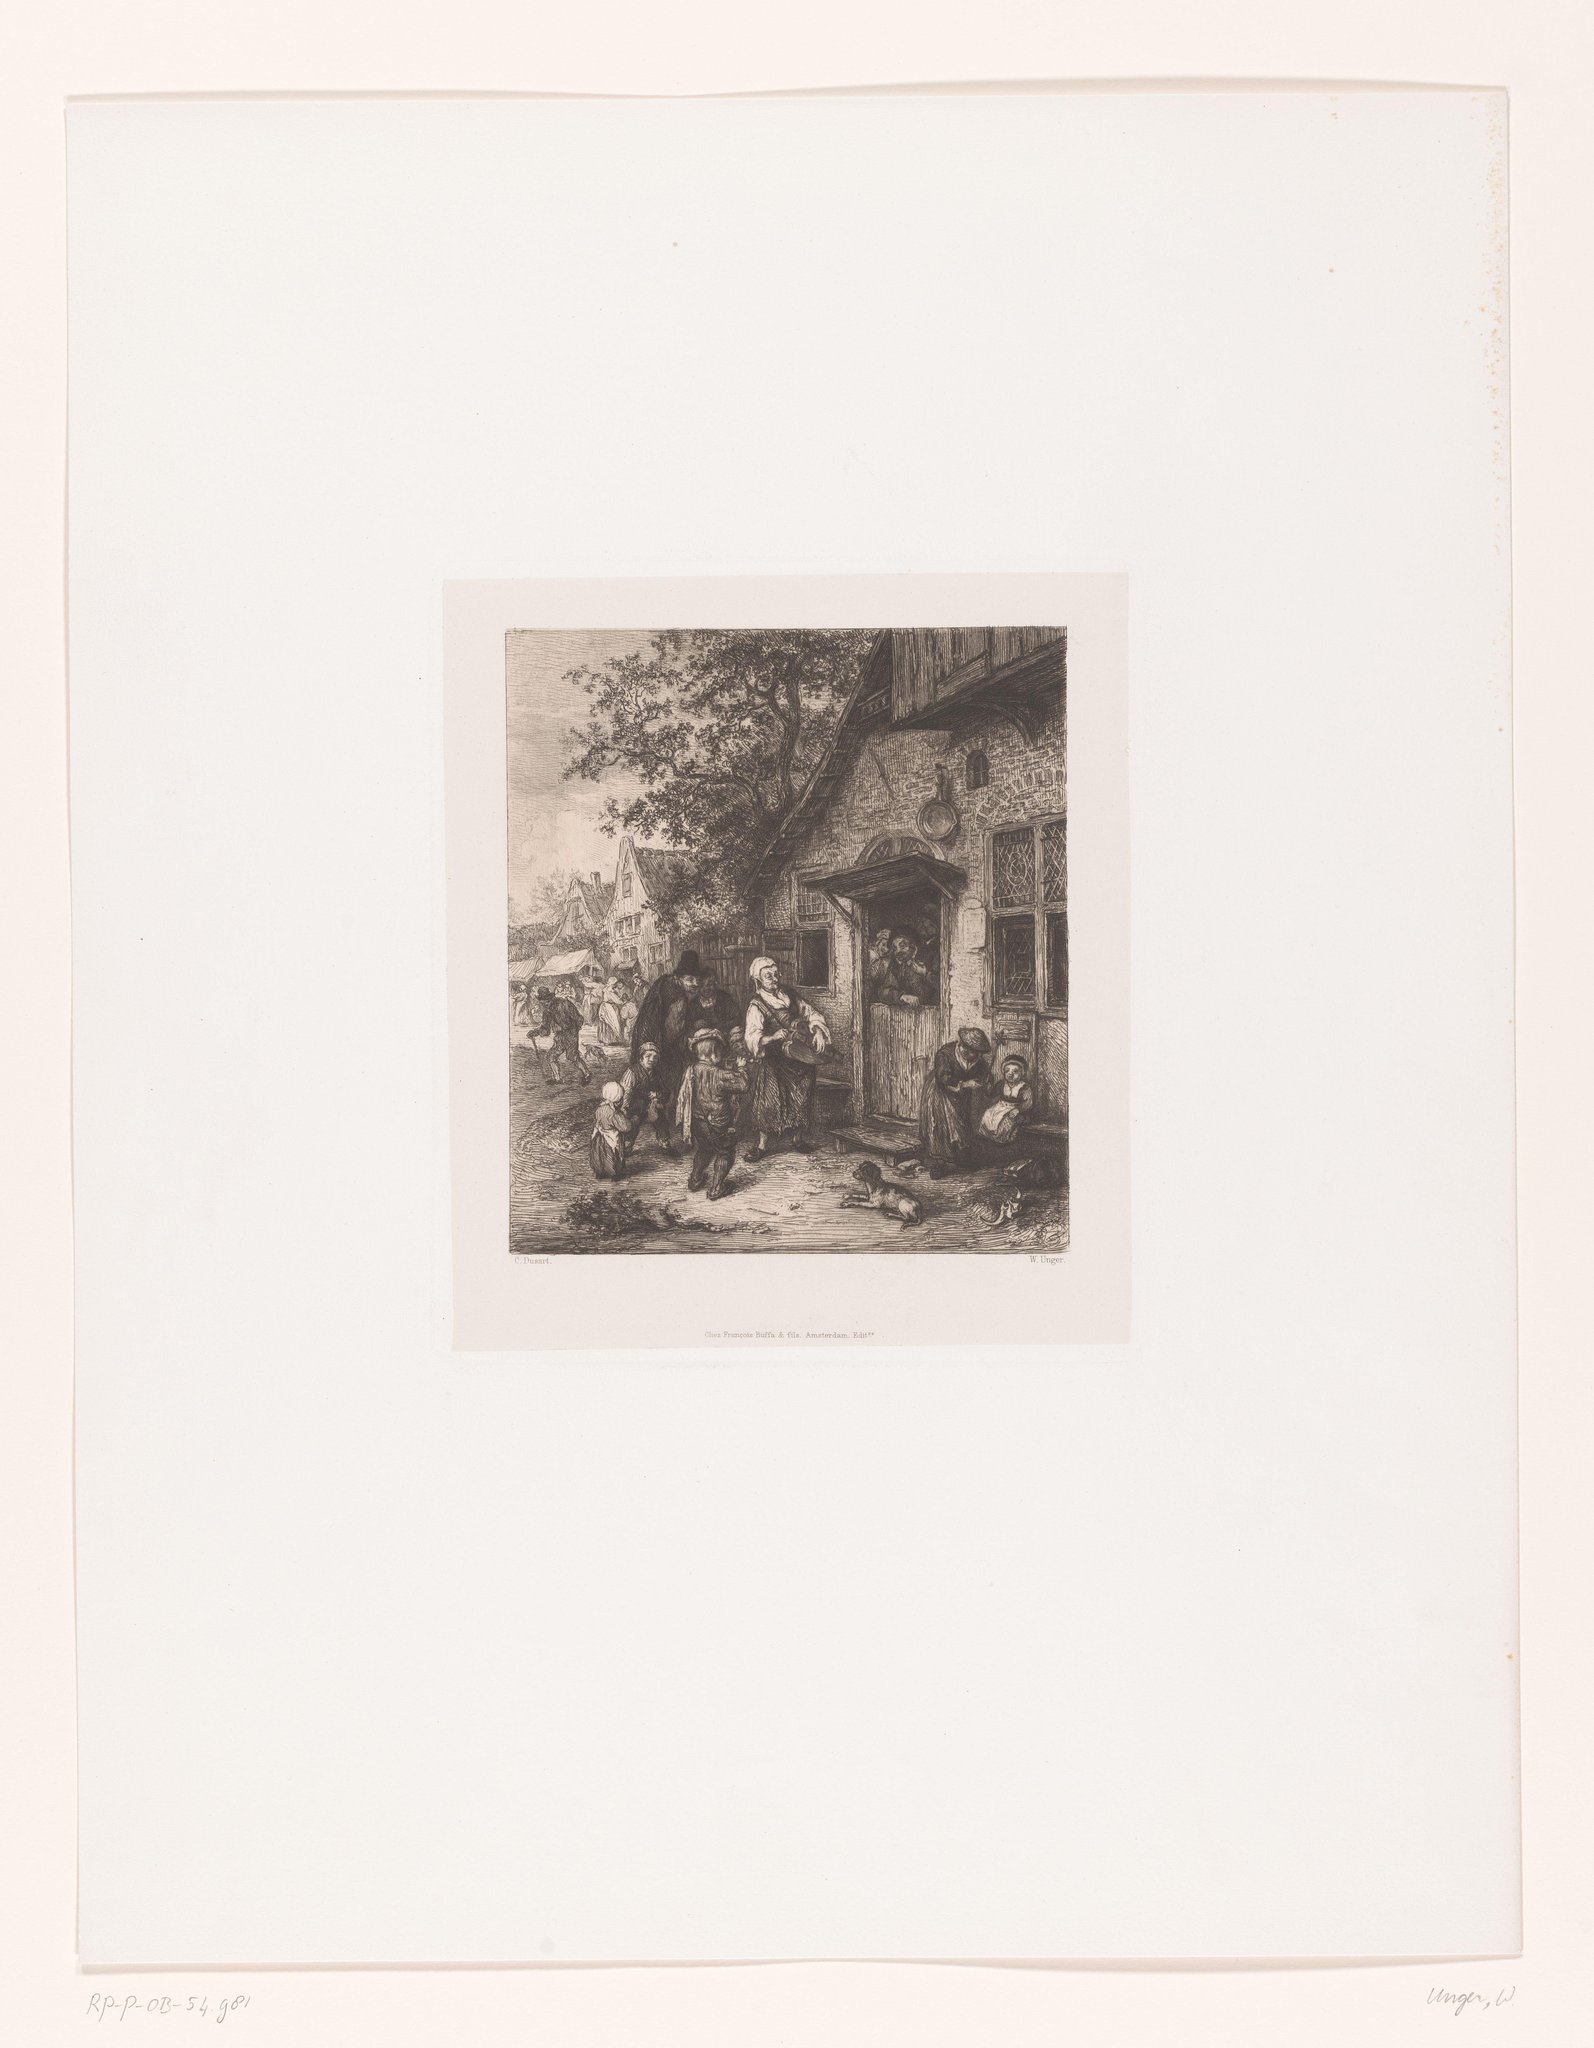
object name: print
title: Boerenkermis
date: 1847-1889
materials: paper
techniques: etching, intaglio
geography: germany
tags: hurdy-gurdy - cc - out of doors, village street, flute, aulos, tibia - cc - out of doors, festivities